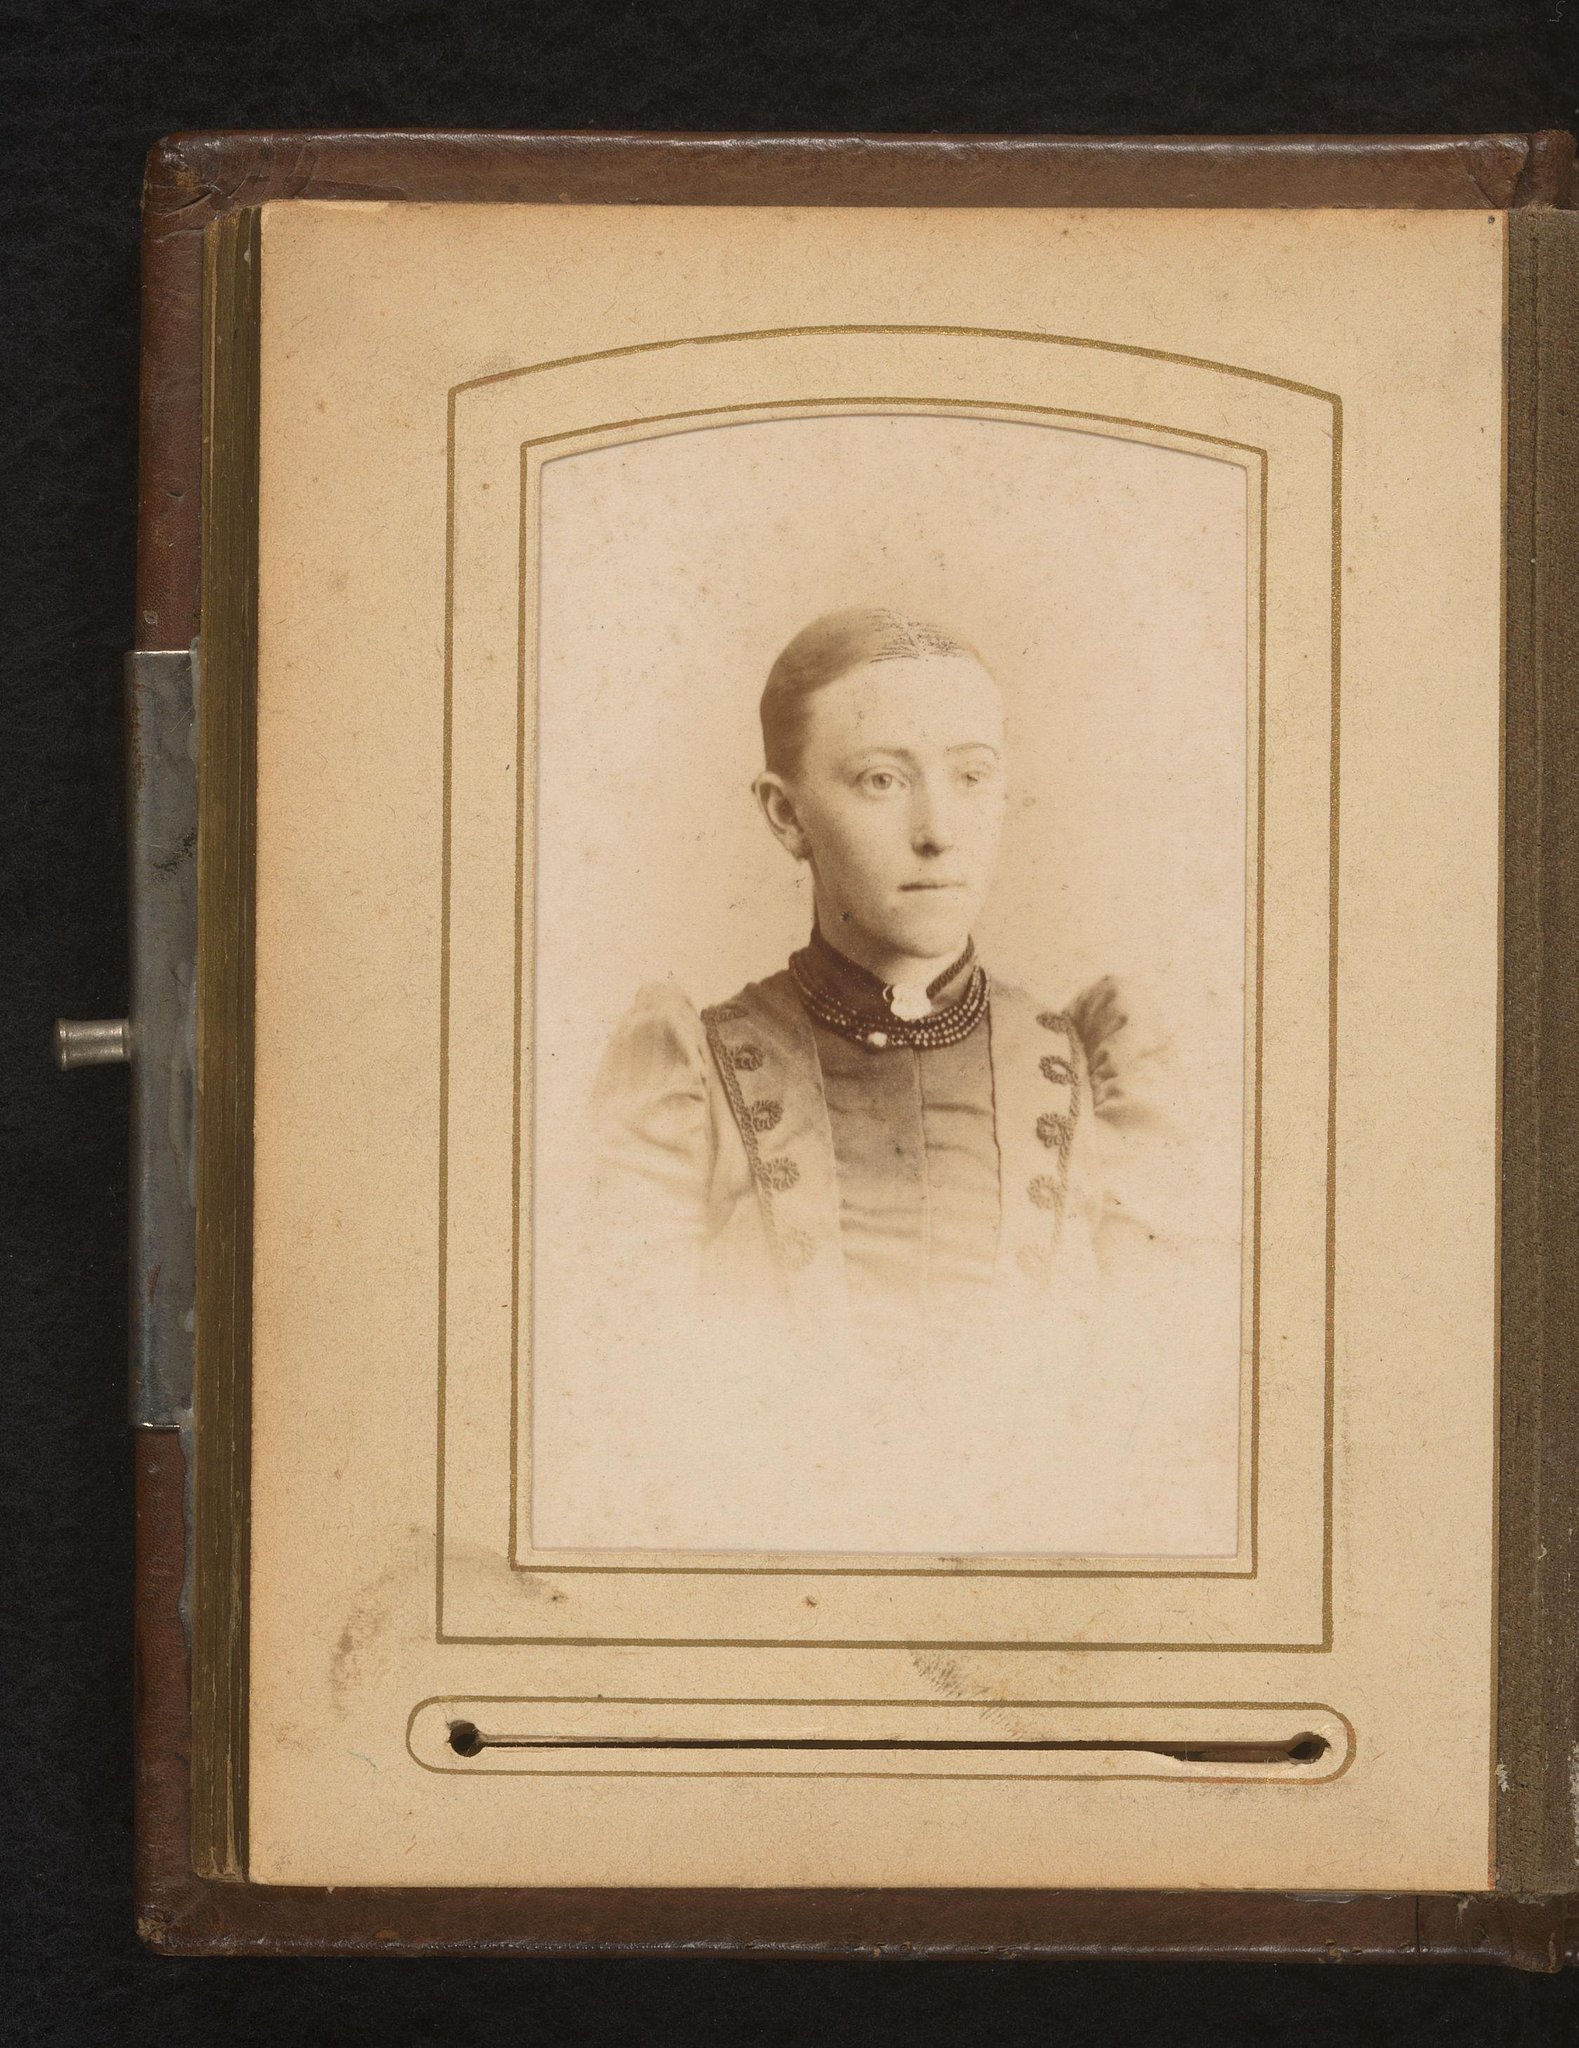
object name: carte de visite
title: Portret van een vrouw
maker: august ferdinand heinrich harms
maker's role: fotograaf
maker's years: 1845-1916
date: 1884-1900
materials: cardboard, photographic support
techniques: albumen print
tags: adult woman, historical persons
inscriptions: inscription: ‘A.F.H. Harms/ Haarlem/ Zylweg 75.’